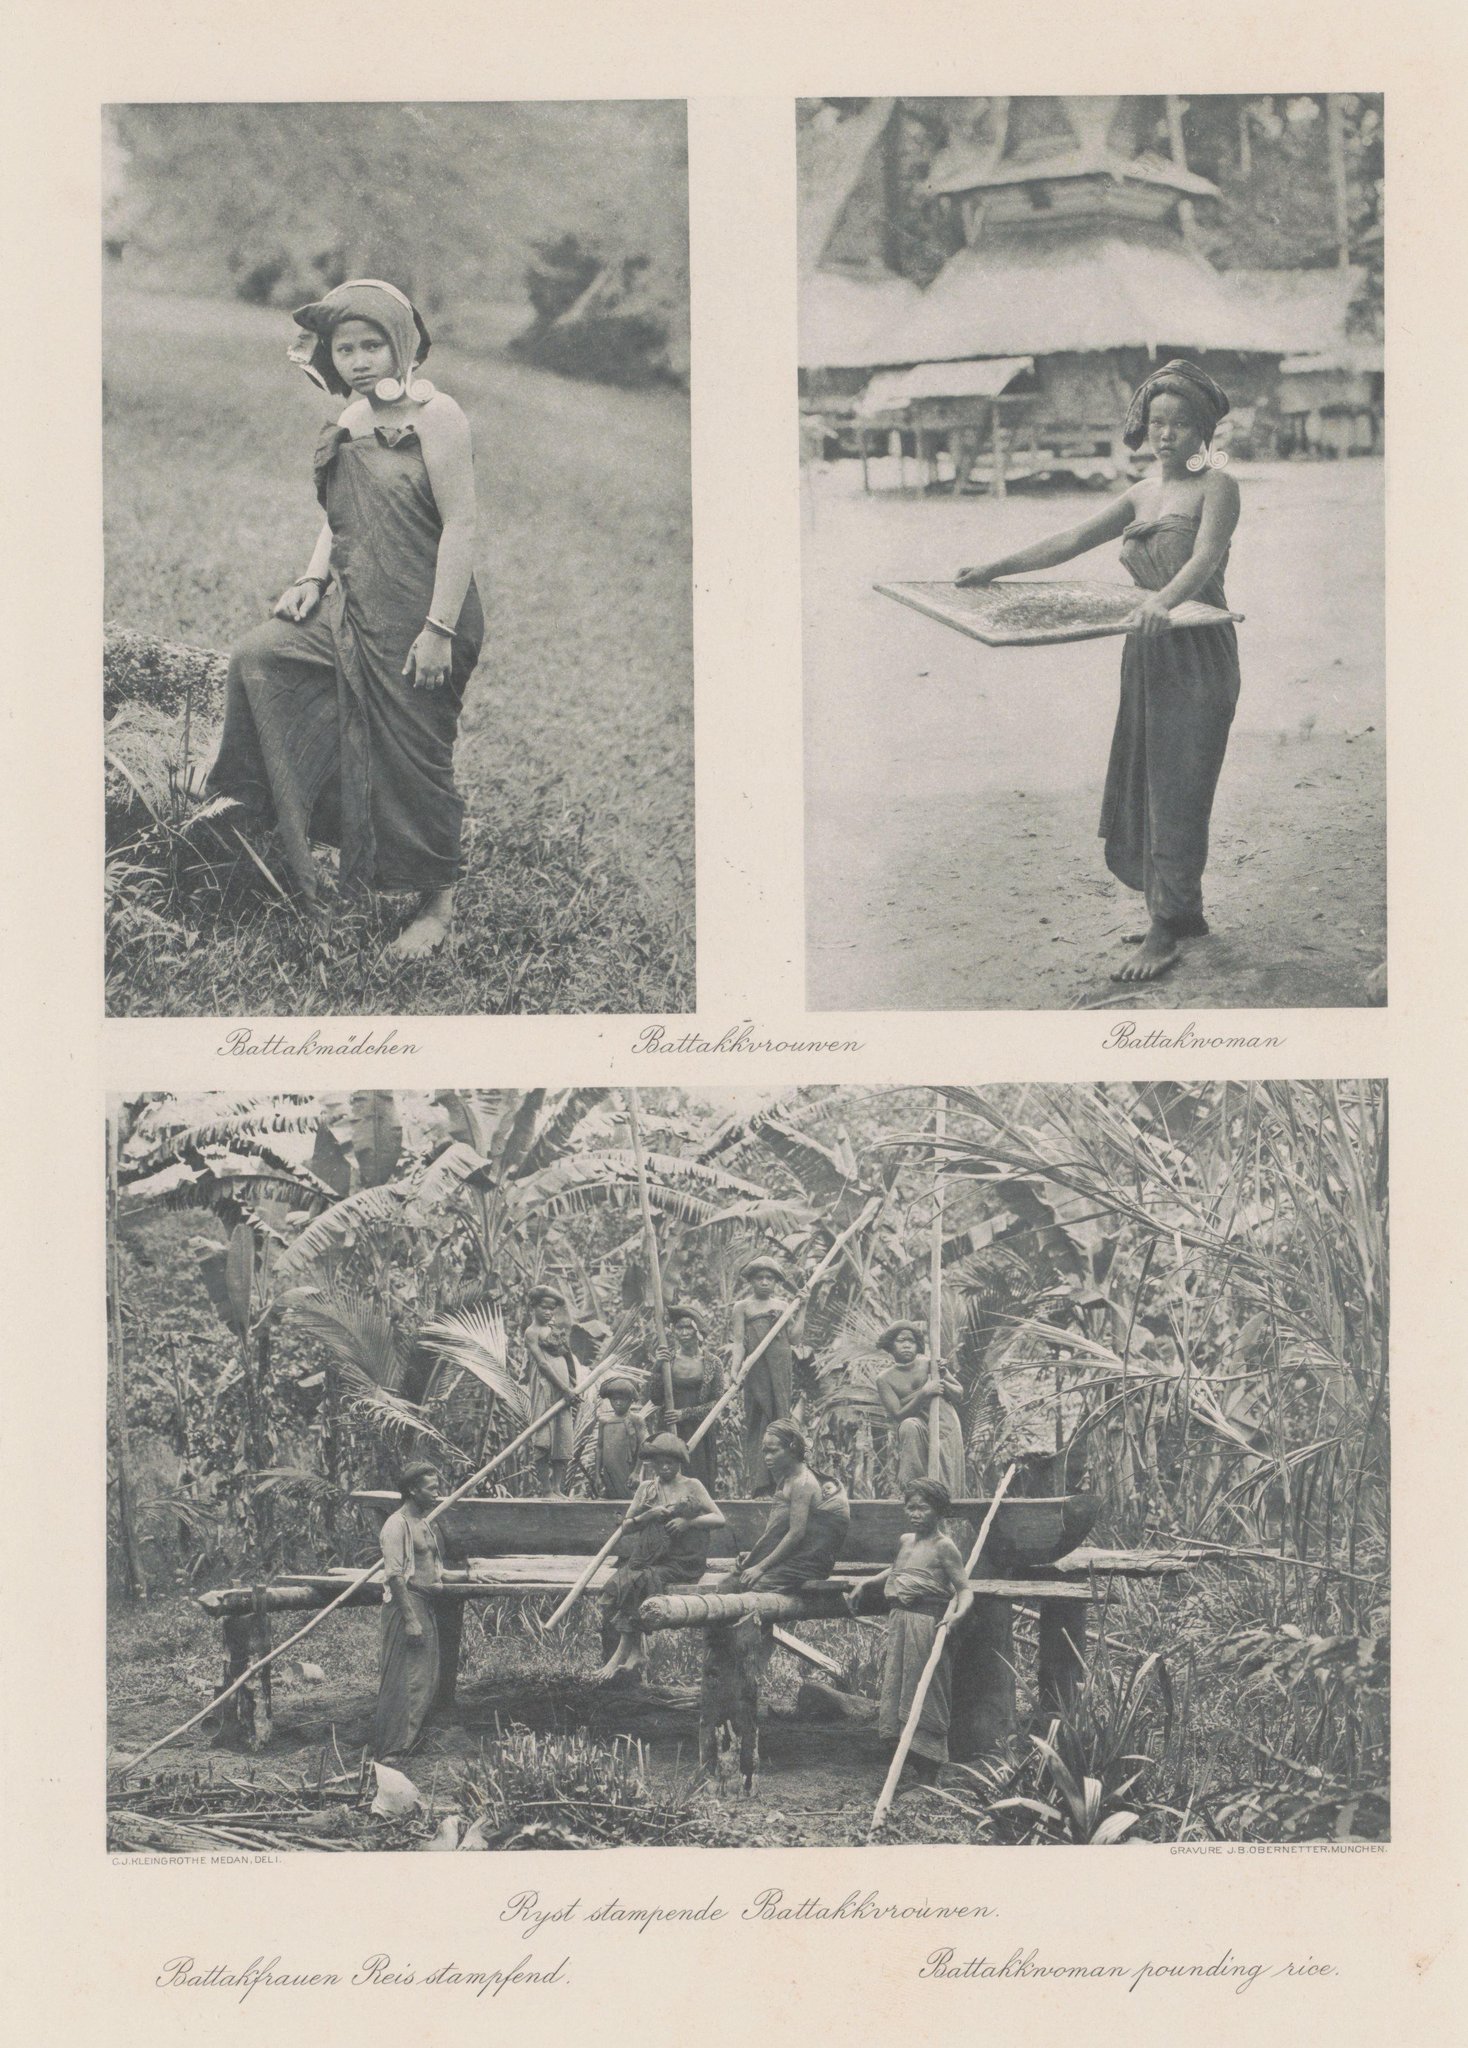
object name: photomechanical print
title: Batakkvrouwen (boven), Rijst stampende Batakkvrouwen (onder)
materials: paper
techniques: photoaquatint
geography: munich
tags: adolescent, young woman, maiden, adult woman, sumatra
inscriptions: number: ‘51’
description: Onderdeel van Album met heliogravures van Sumatra's oostkust.